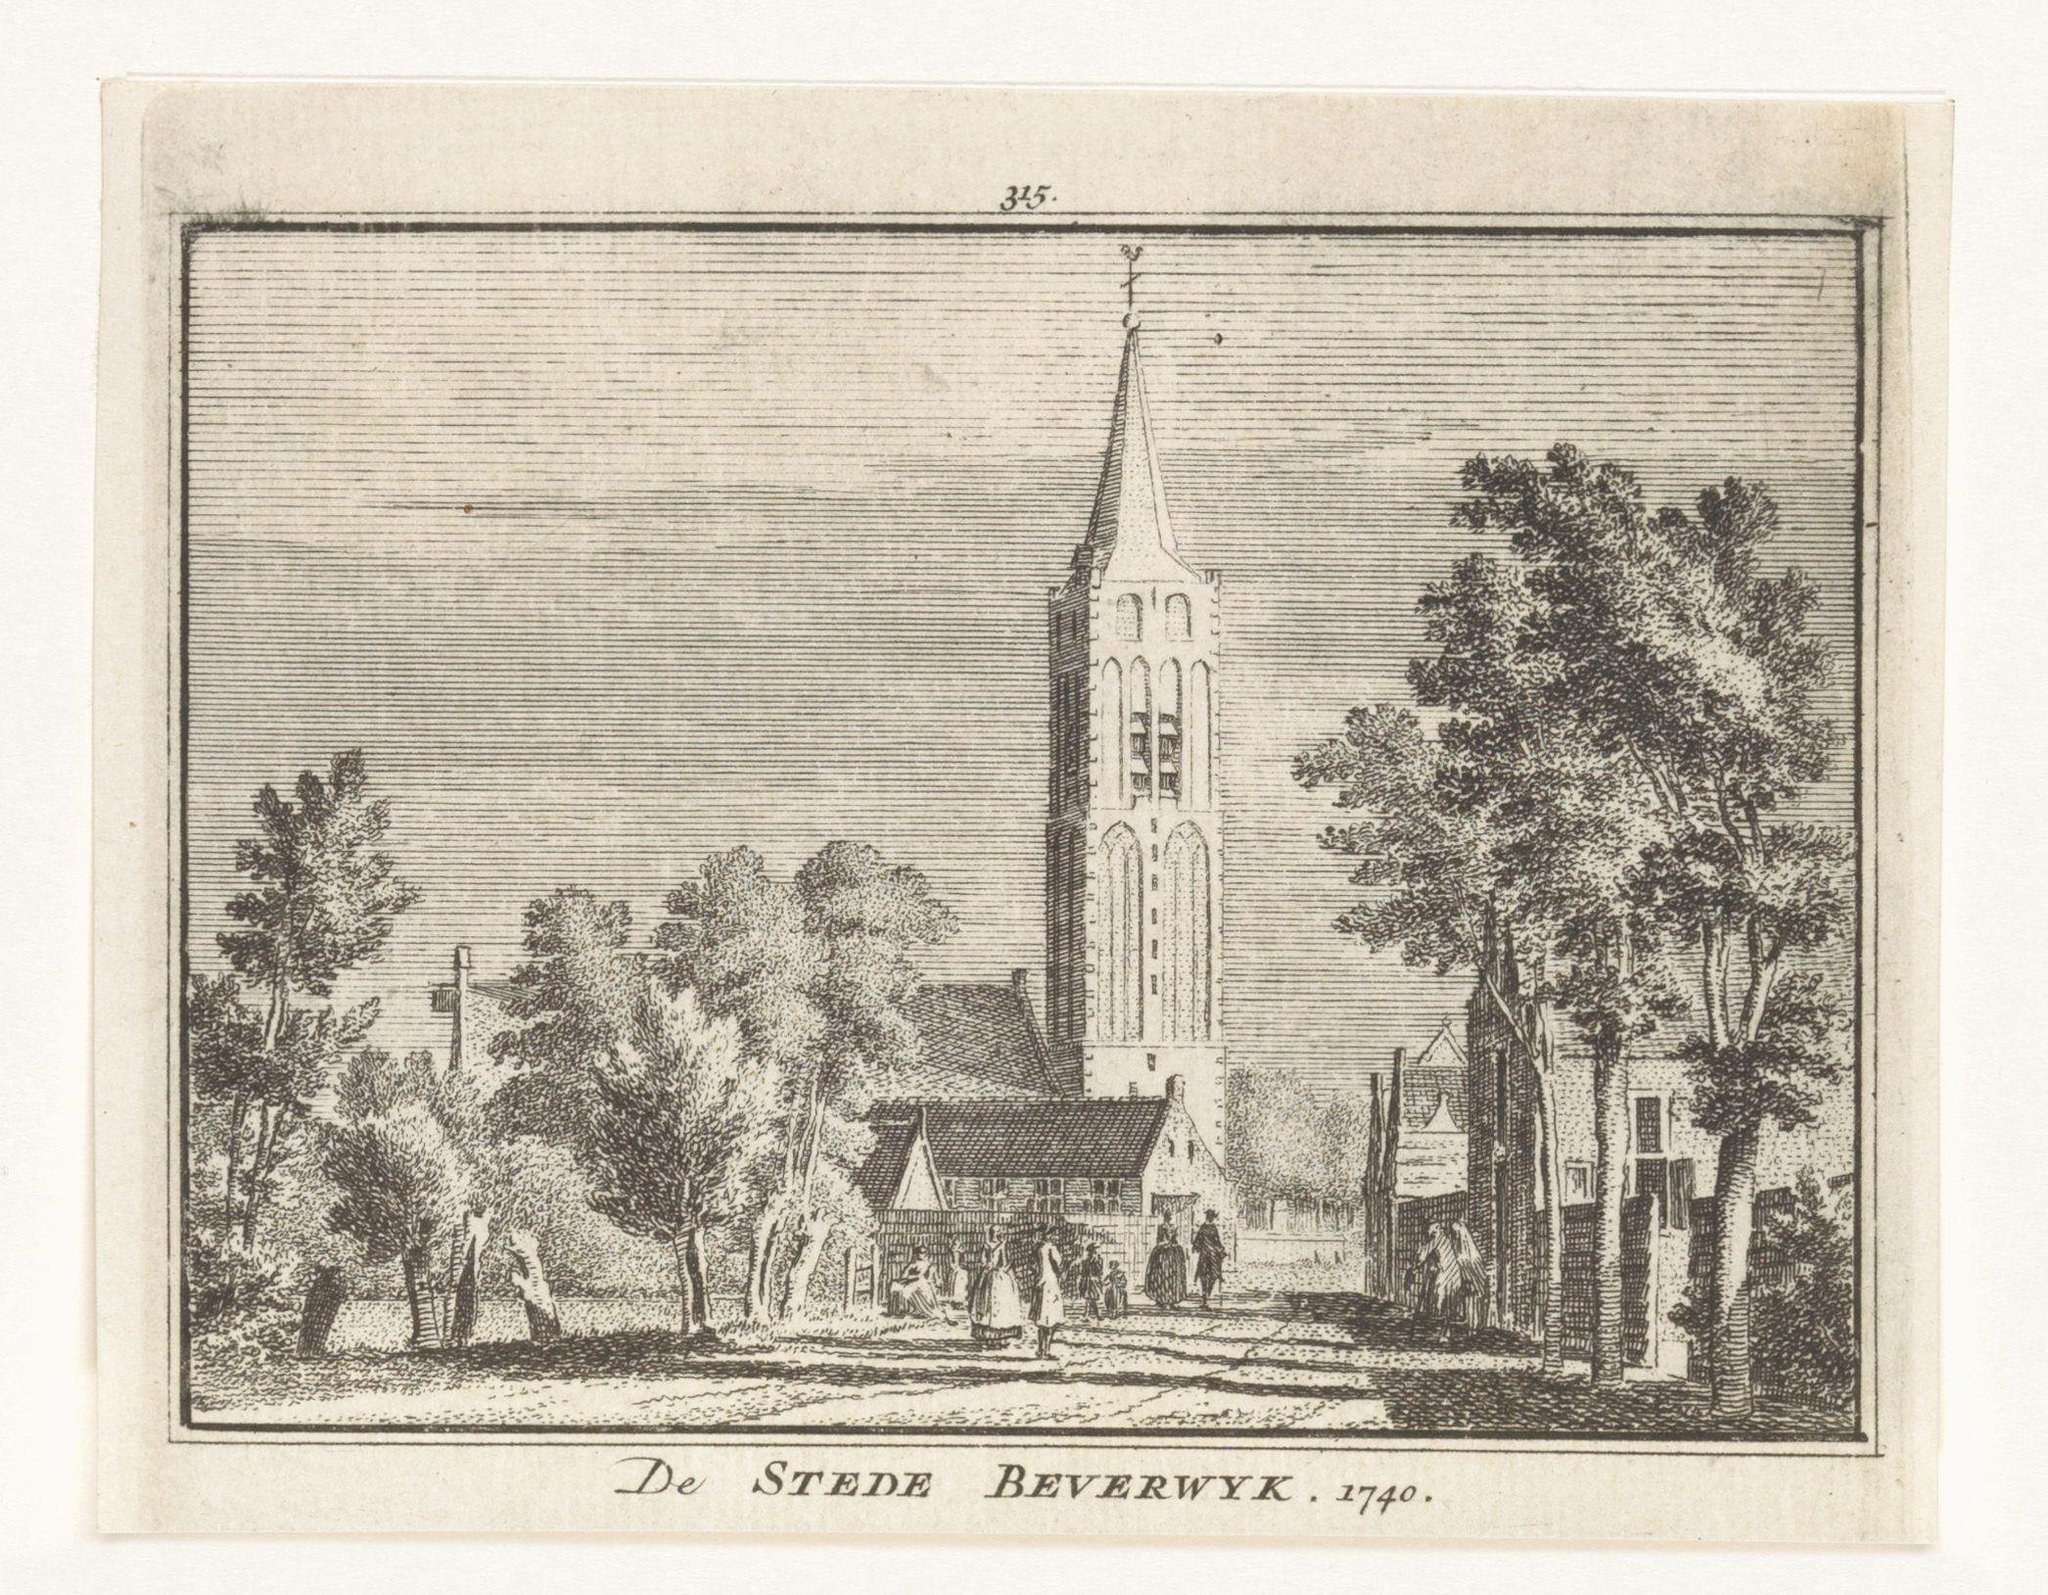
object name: print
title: Gezicht op Beverwijk, 1740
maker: hendrik spilman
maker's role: draughtsman, painter, print maker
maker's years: 1721-1784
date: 1752-1792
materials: paper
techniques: engraving, etching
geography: haarlem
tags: church (exterior), prospect of city, town panorama, silhouette of city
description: Prent ook gebruikt in: Het verheerlykt Nederland of kabinet van hedendaagsche gezigten van steden, dorpen (…). 9 delen. Amsterdam: Isaak Tirion en weduwe Isaak Tirion, 1745-1774, dl. 4 (1752), ill. 315. Of in: Nederlandsche tafereelen; of eene keurige verzameling van negen honderd fraaije gezigten van steden, dorpen, sloten, oudheden (….). 9 delen. Amsterdam: Jan de Groot, 1792, dl. 4, ill. 315. Uit welke druk het huidige exemplaar precies komt is niet na te gaan.